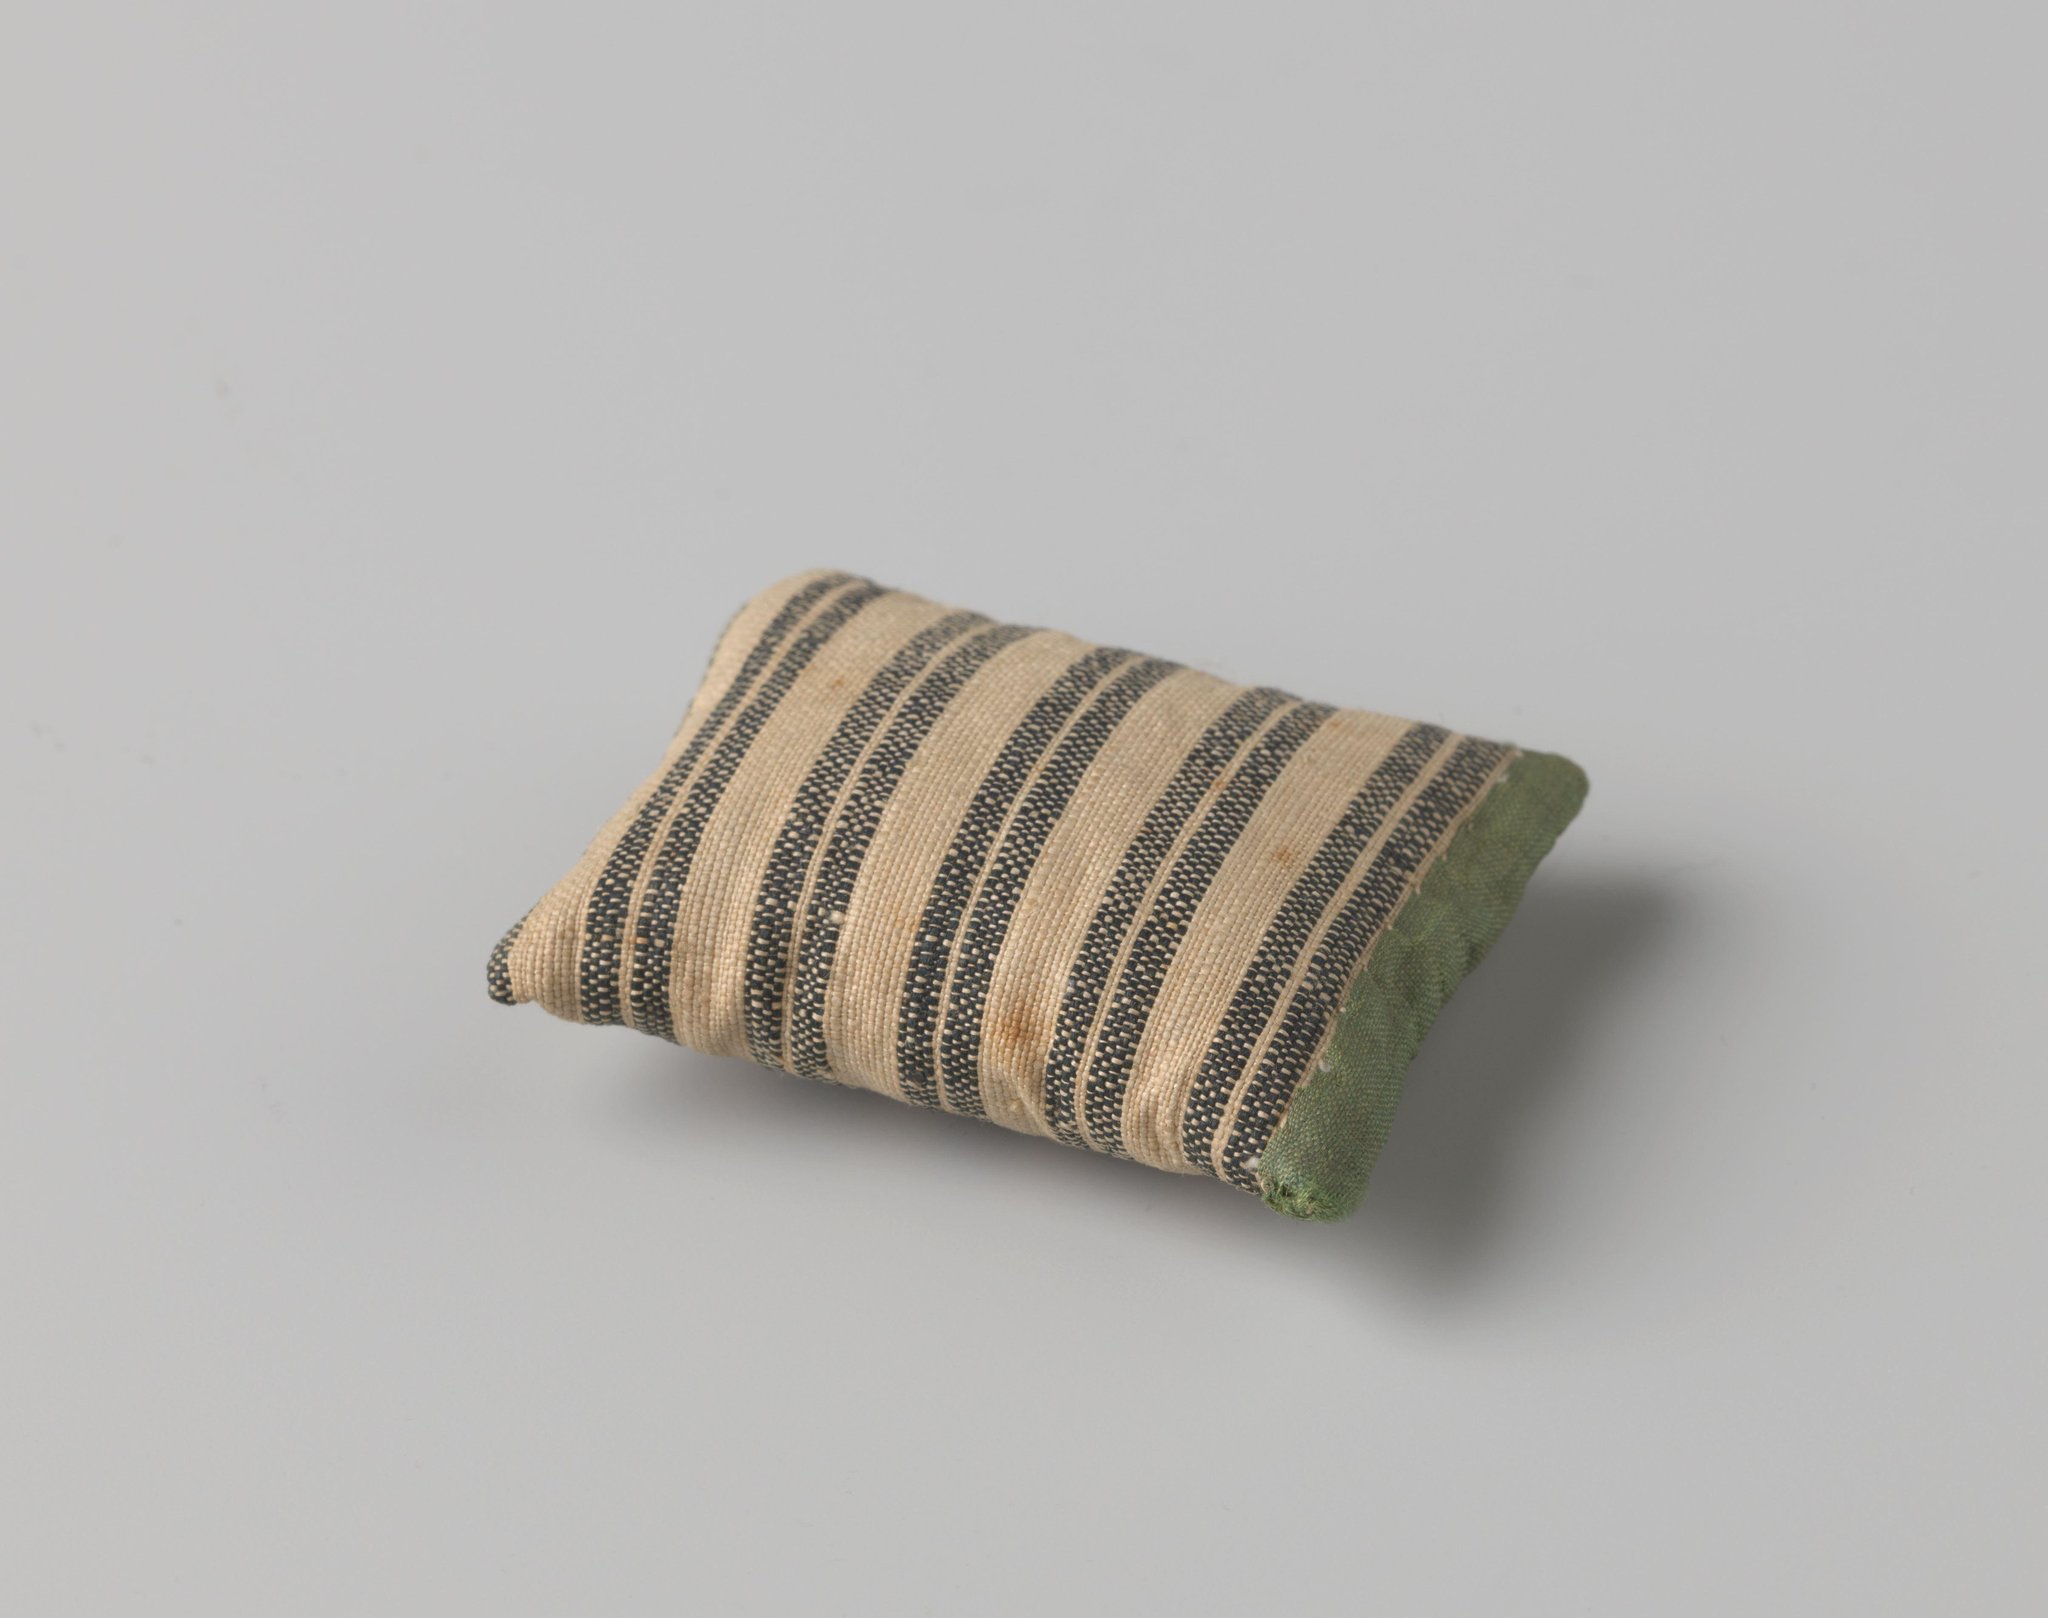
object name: miniature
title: Kussen, blauw-wit gestreept, afgezet met groen koord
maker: Anonymous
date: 1750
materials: cotton, down, linen, silk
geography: amsterdam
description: Kussen van blauw wit gestreepte stof (wit linnen, blauw katoen) gevuld met dons. Aan linker, respectievelijk rechterzijde afgezet met een groen zijden blinkerd.